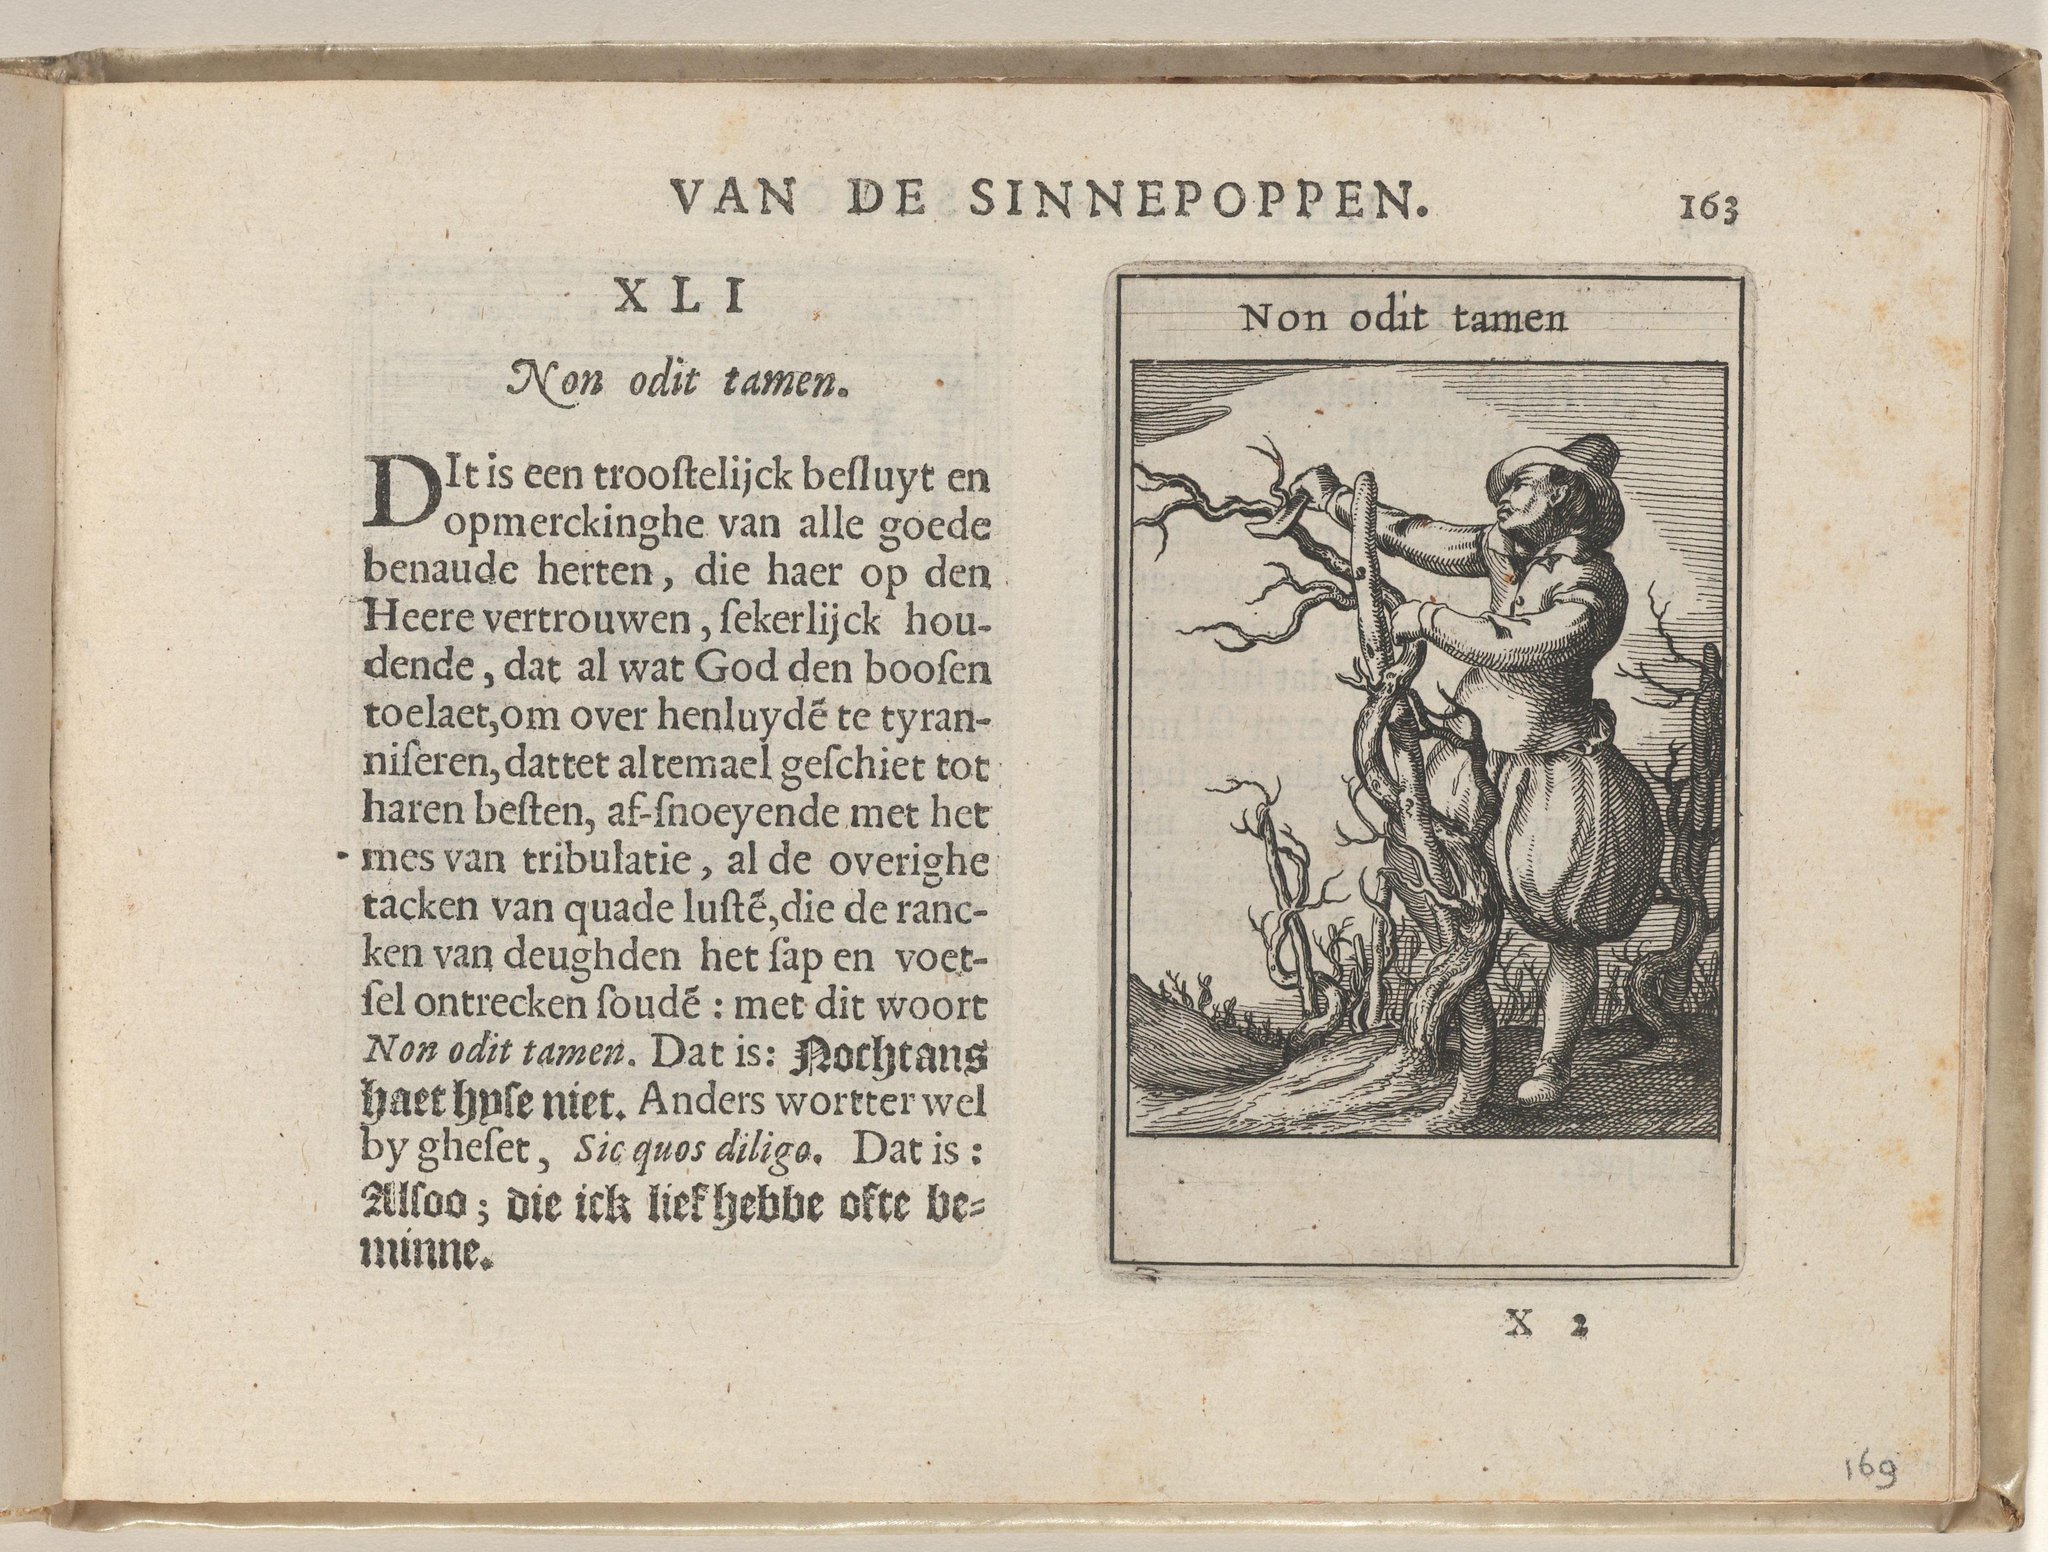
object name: album leaf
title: XLI Non odit tamen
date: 1614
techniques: engraving, printing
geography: amsterdam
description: XLI Non odit tamen. Derde schok. Onderdeel van 'Sinnepoppen', R. Visscher, 1614.